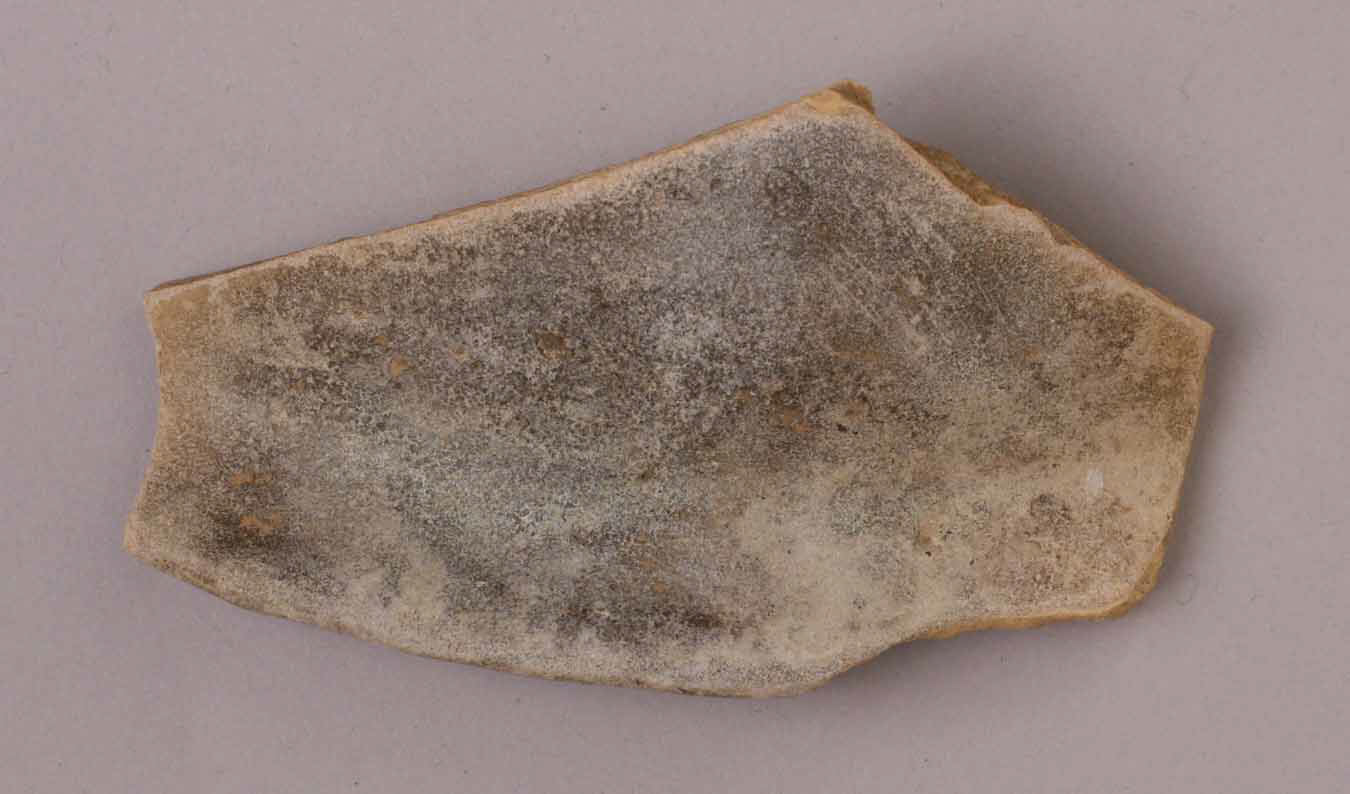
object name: fragment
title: Ceramic Fragment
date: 701-900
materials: earthenware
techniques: glazing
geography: iraq